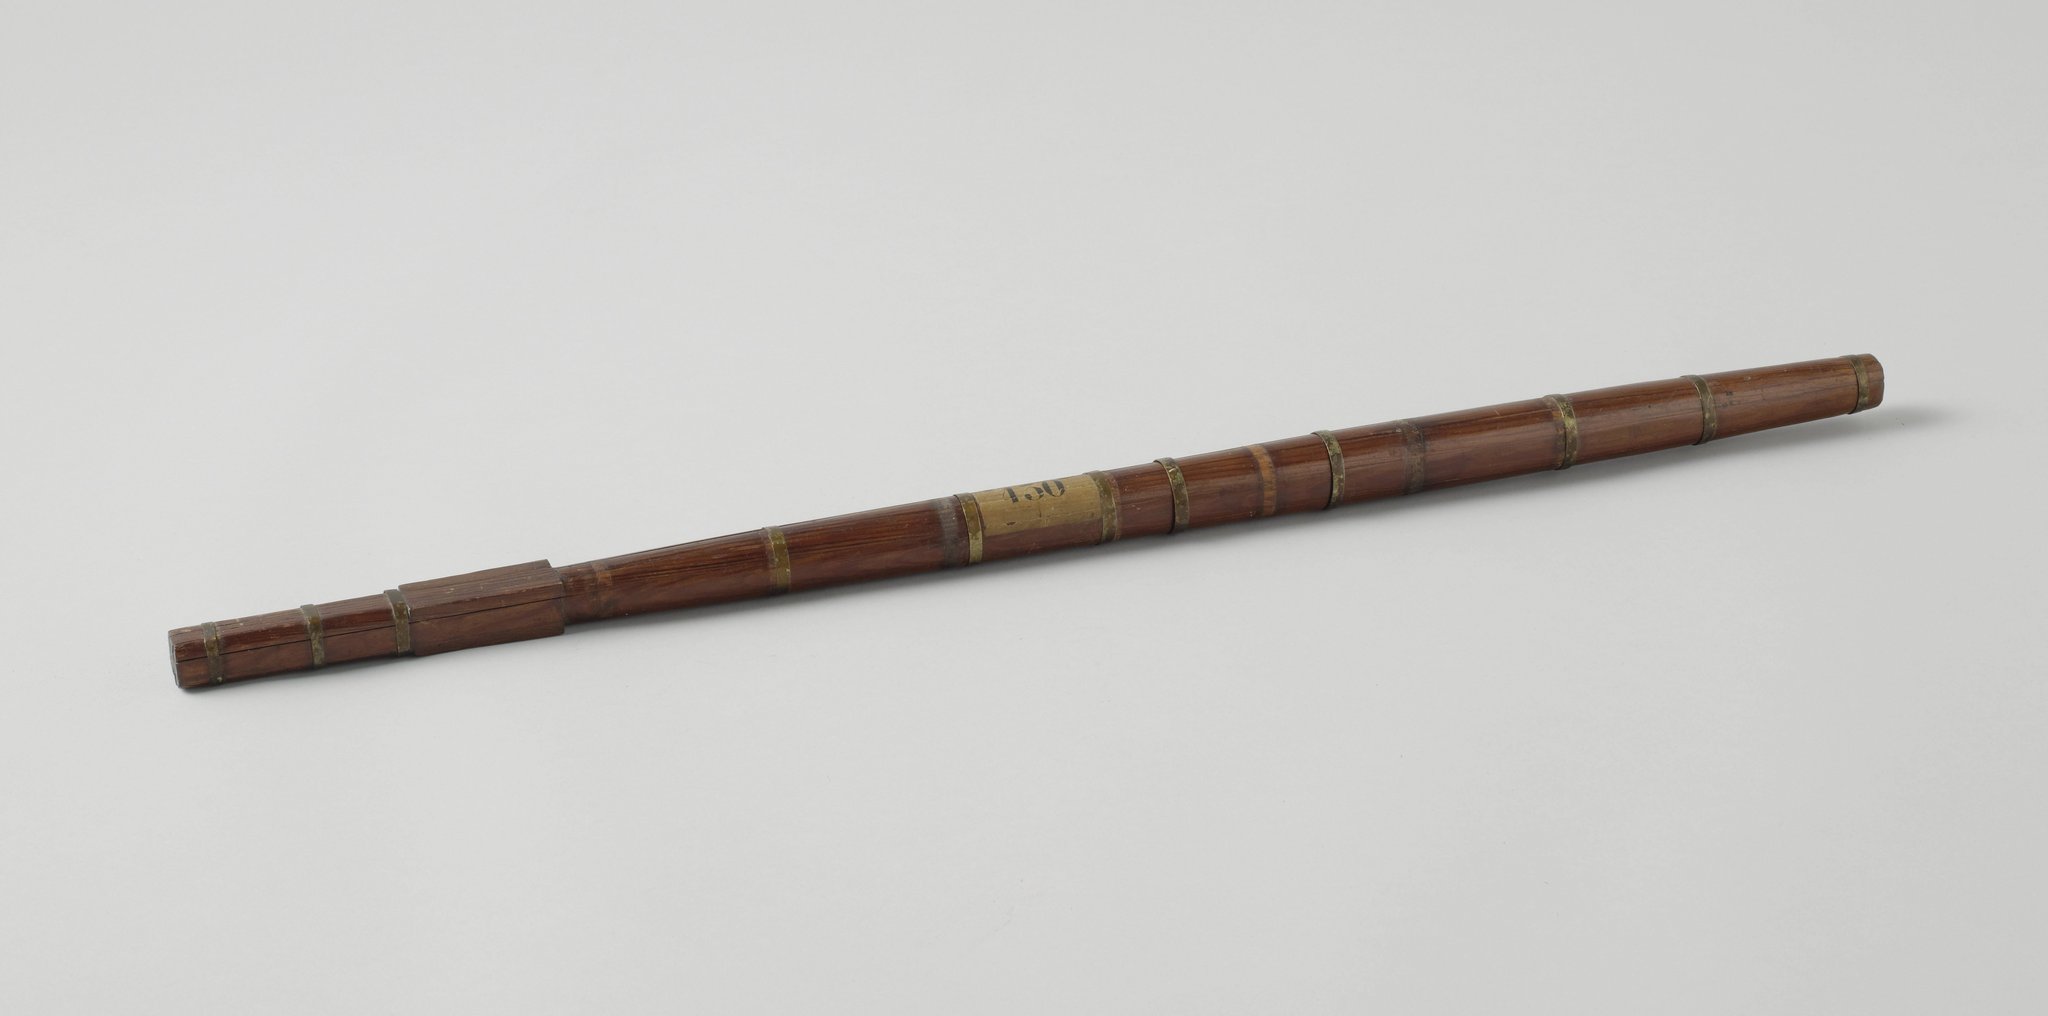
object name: demonstration model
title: Model of a Made Mast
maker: Anonymous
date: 1780-1840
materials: brass, wood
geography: netherlands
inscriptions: label: ‘130’ former inventory label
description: Ronde mast met vierkante top. De mast zelf bestaat uit een achtkantige mastkoning omringd door acht wangen. De delen worden door kuipbanden bijeengehouden. Ter hoogte van de hommer en de mars wordt de mast vierkant; daarboven zijn de hoeken iets afgerond. Dit model kan uiteengenomen worden.